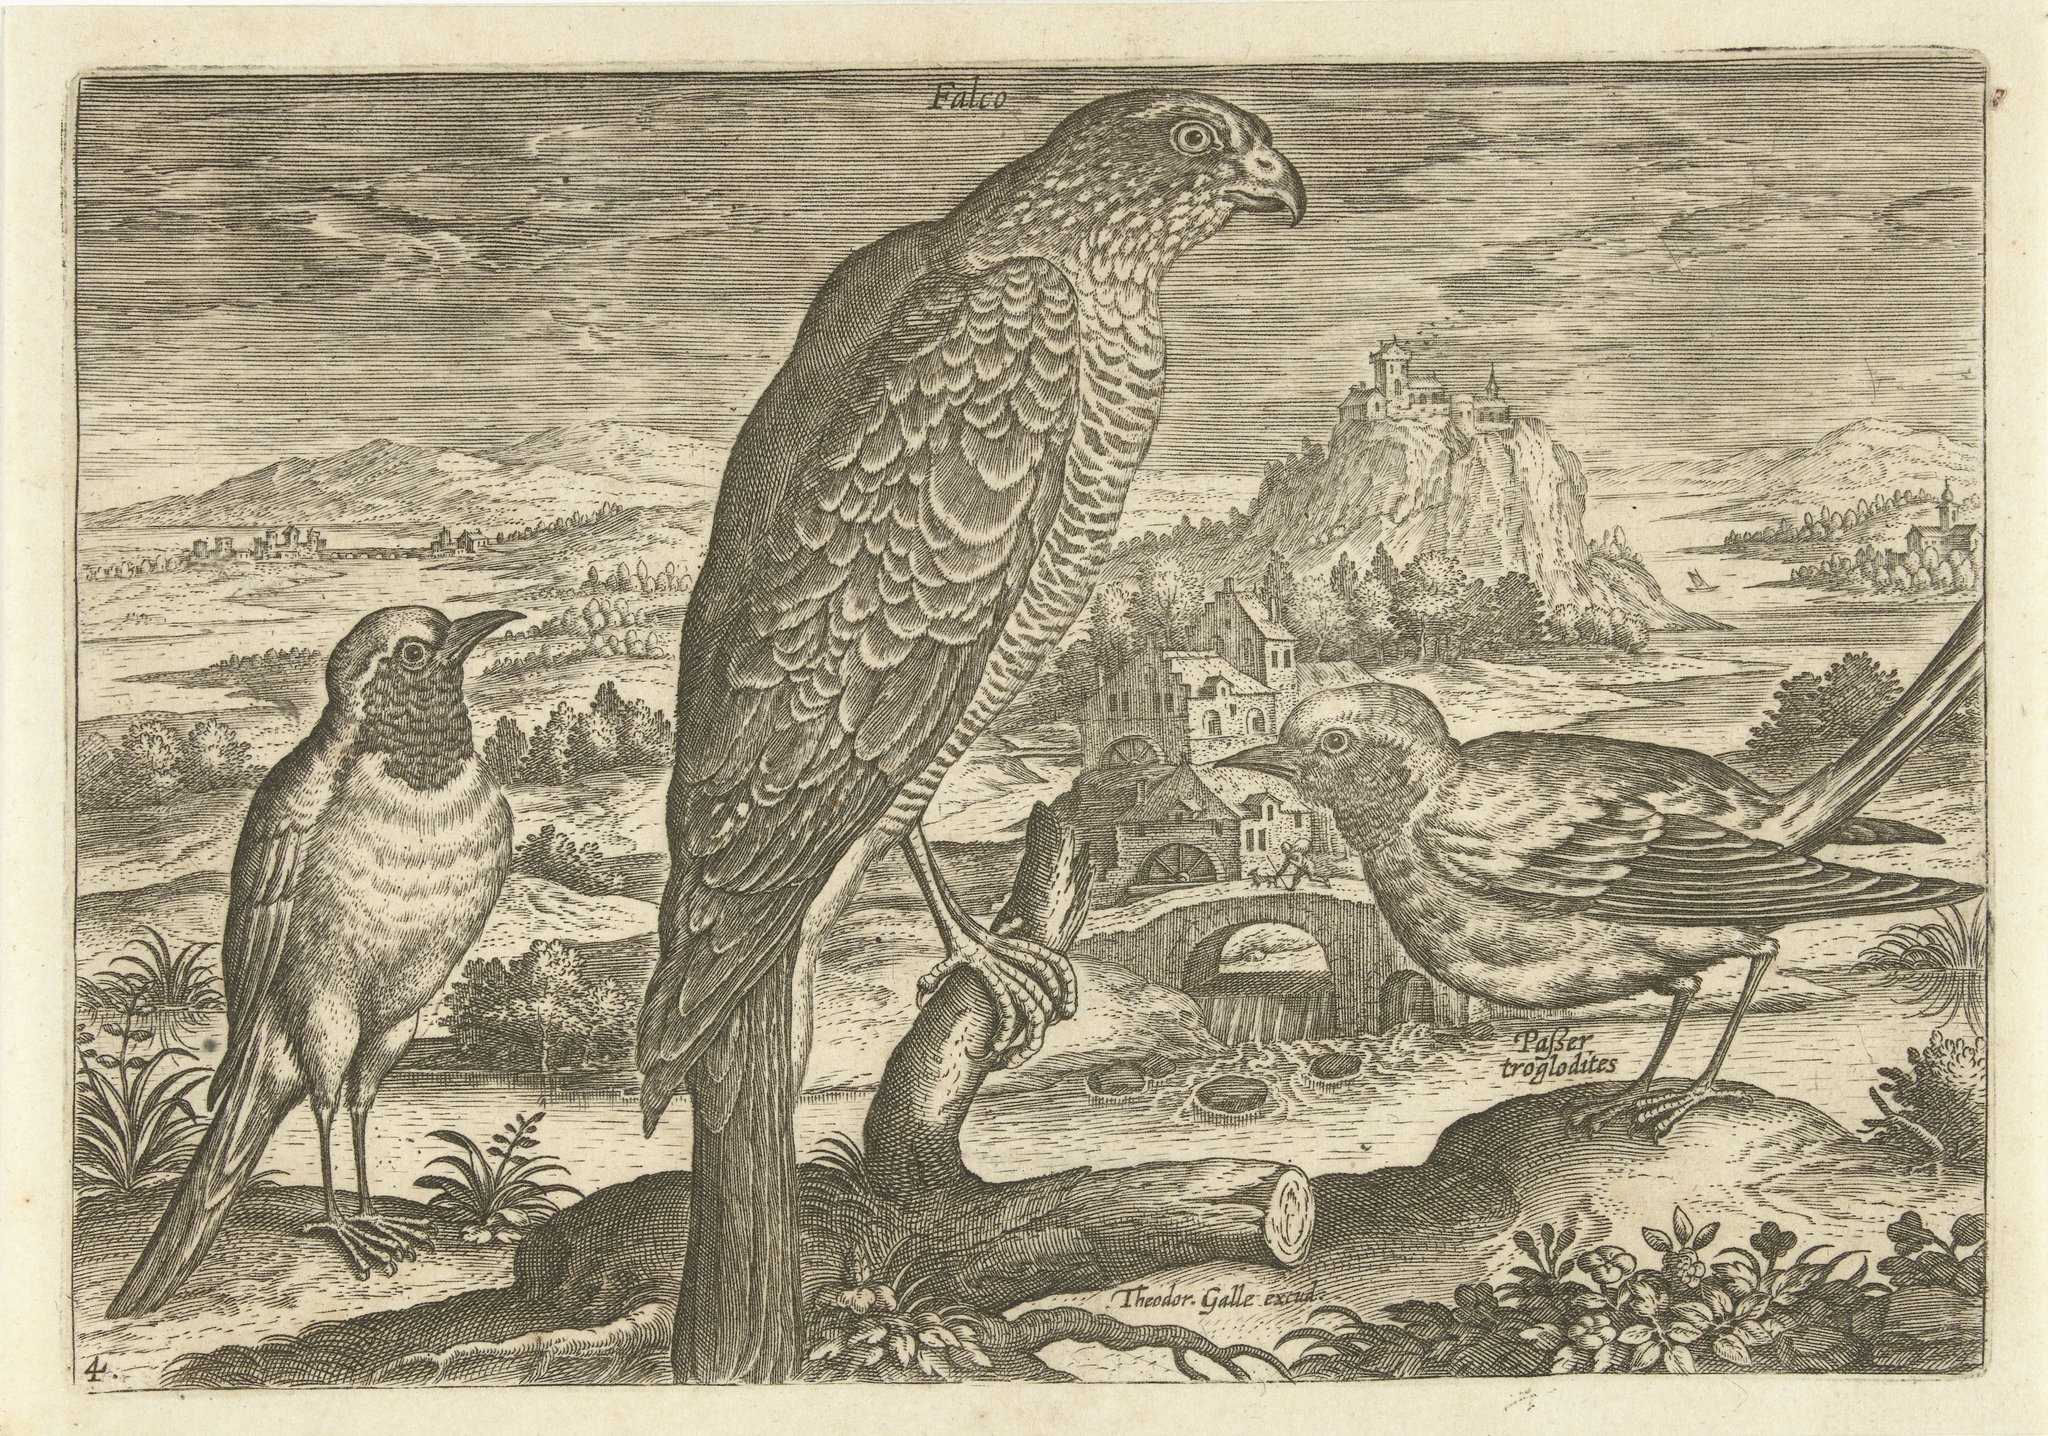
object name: print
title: Avivm vivae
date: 1598-1618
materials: paper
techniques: engraving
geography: antwerp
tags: predatory birds: falcon, river, song-birds: redstart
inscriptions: collector's mark: Lugt 2228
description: Een valk en twee roodstaartjes, in een landschap met een rivier. De prent maakt deel uit van een serie met vogels als onderwerp.